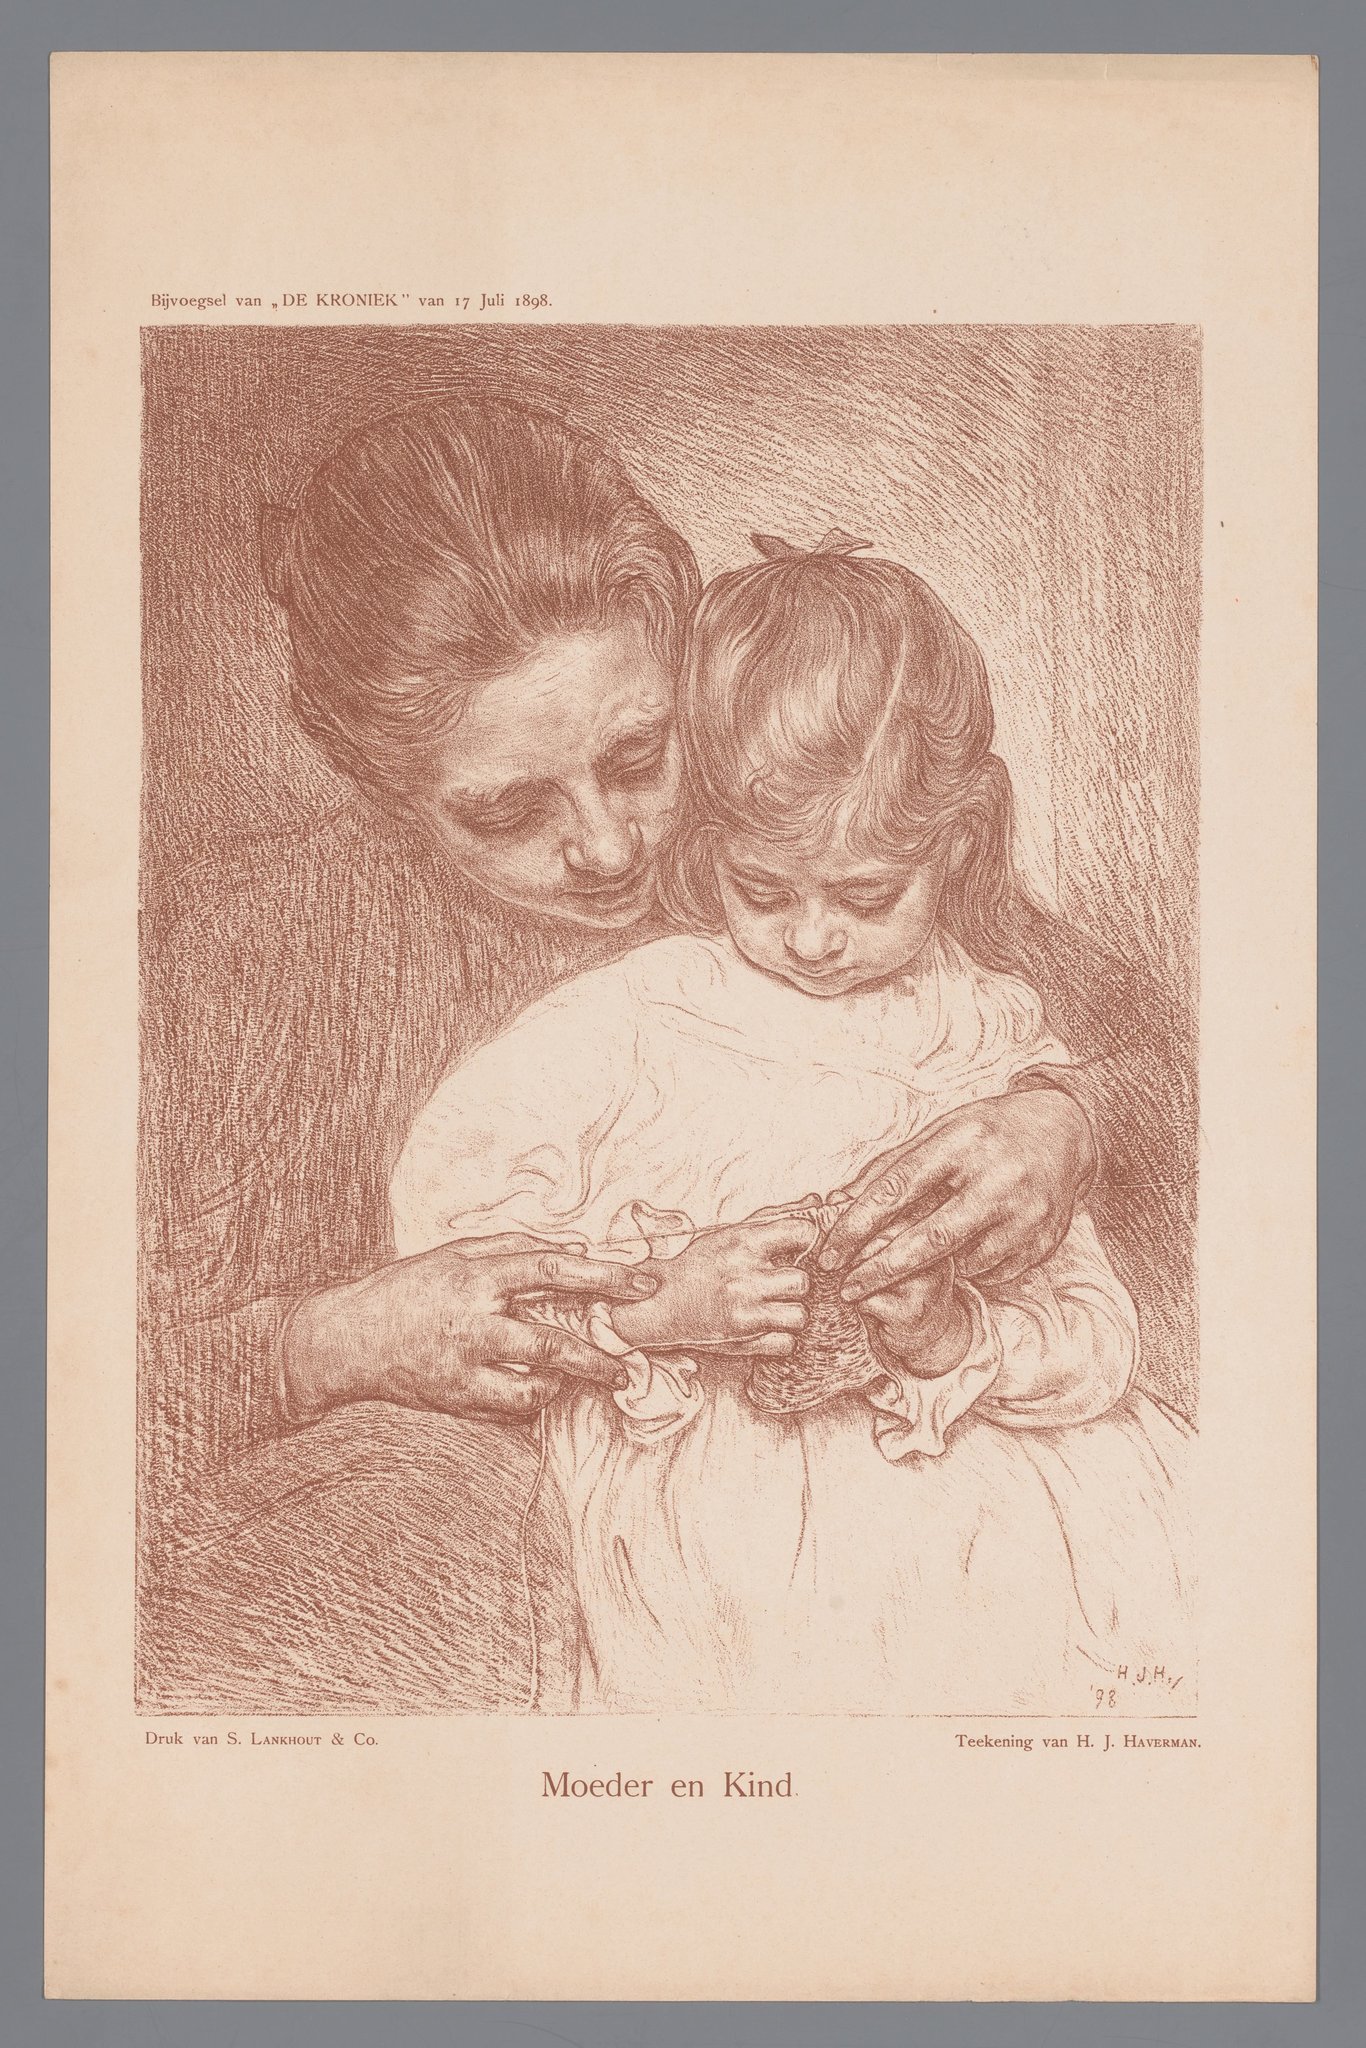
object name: print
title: Moeder en Kind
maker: hendrik johannes haverman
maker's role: draughtsman, print maker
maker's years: 1857-1928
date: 1898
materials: paper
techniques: lithograph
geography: amsterdam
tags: mother with daughter(s) (mother-love), knitting, netherlands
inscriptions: date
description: Prent met titel en onderschrift, bijvoegsel bij 'De Kroniek'. Gesigneerd en gedateerd.